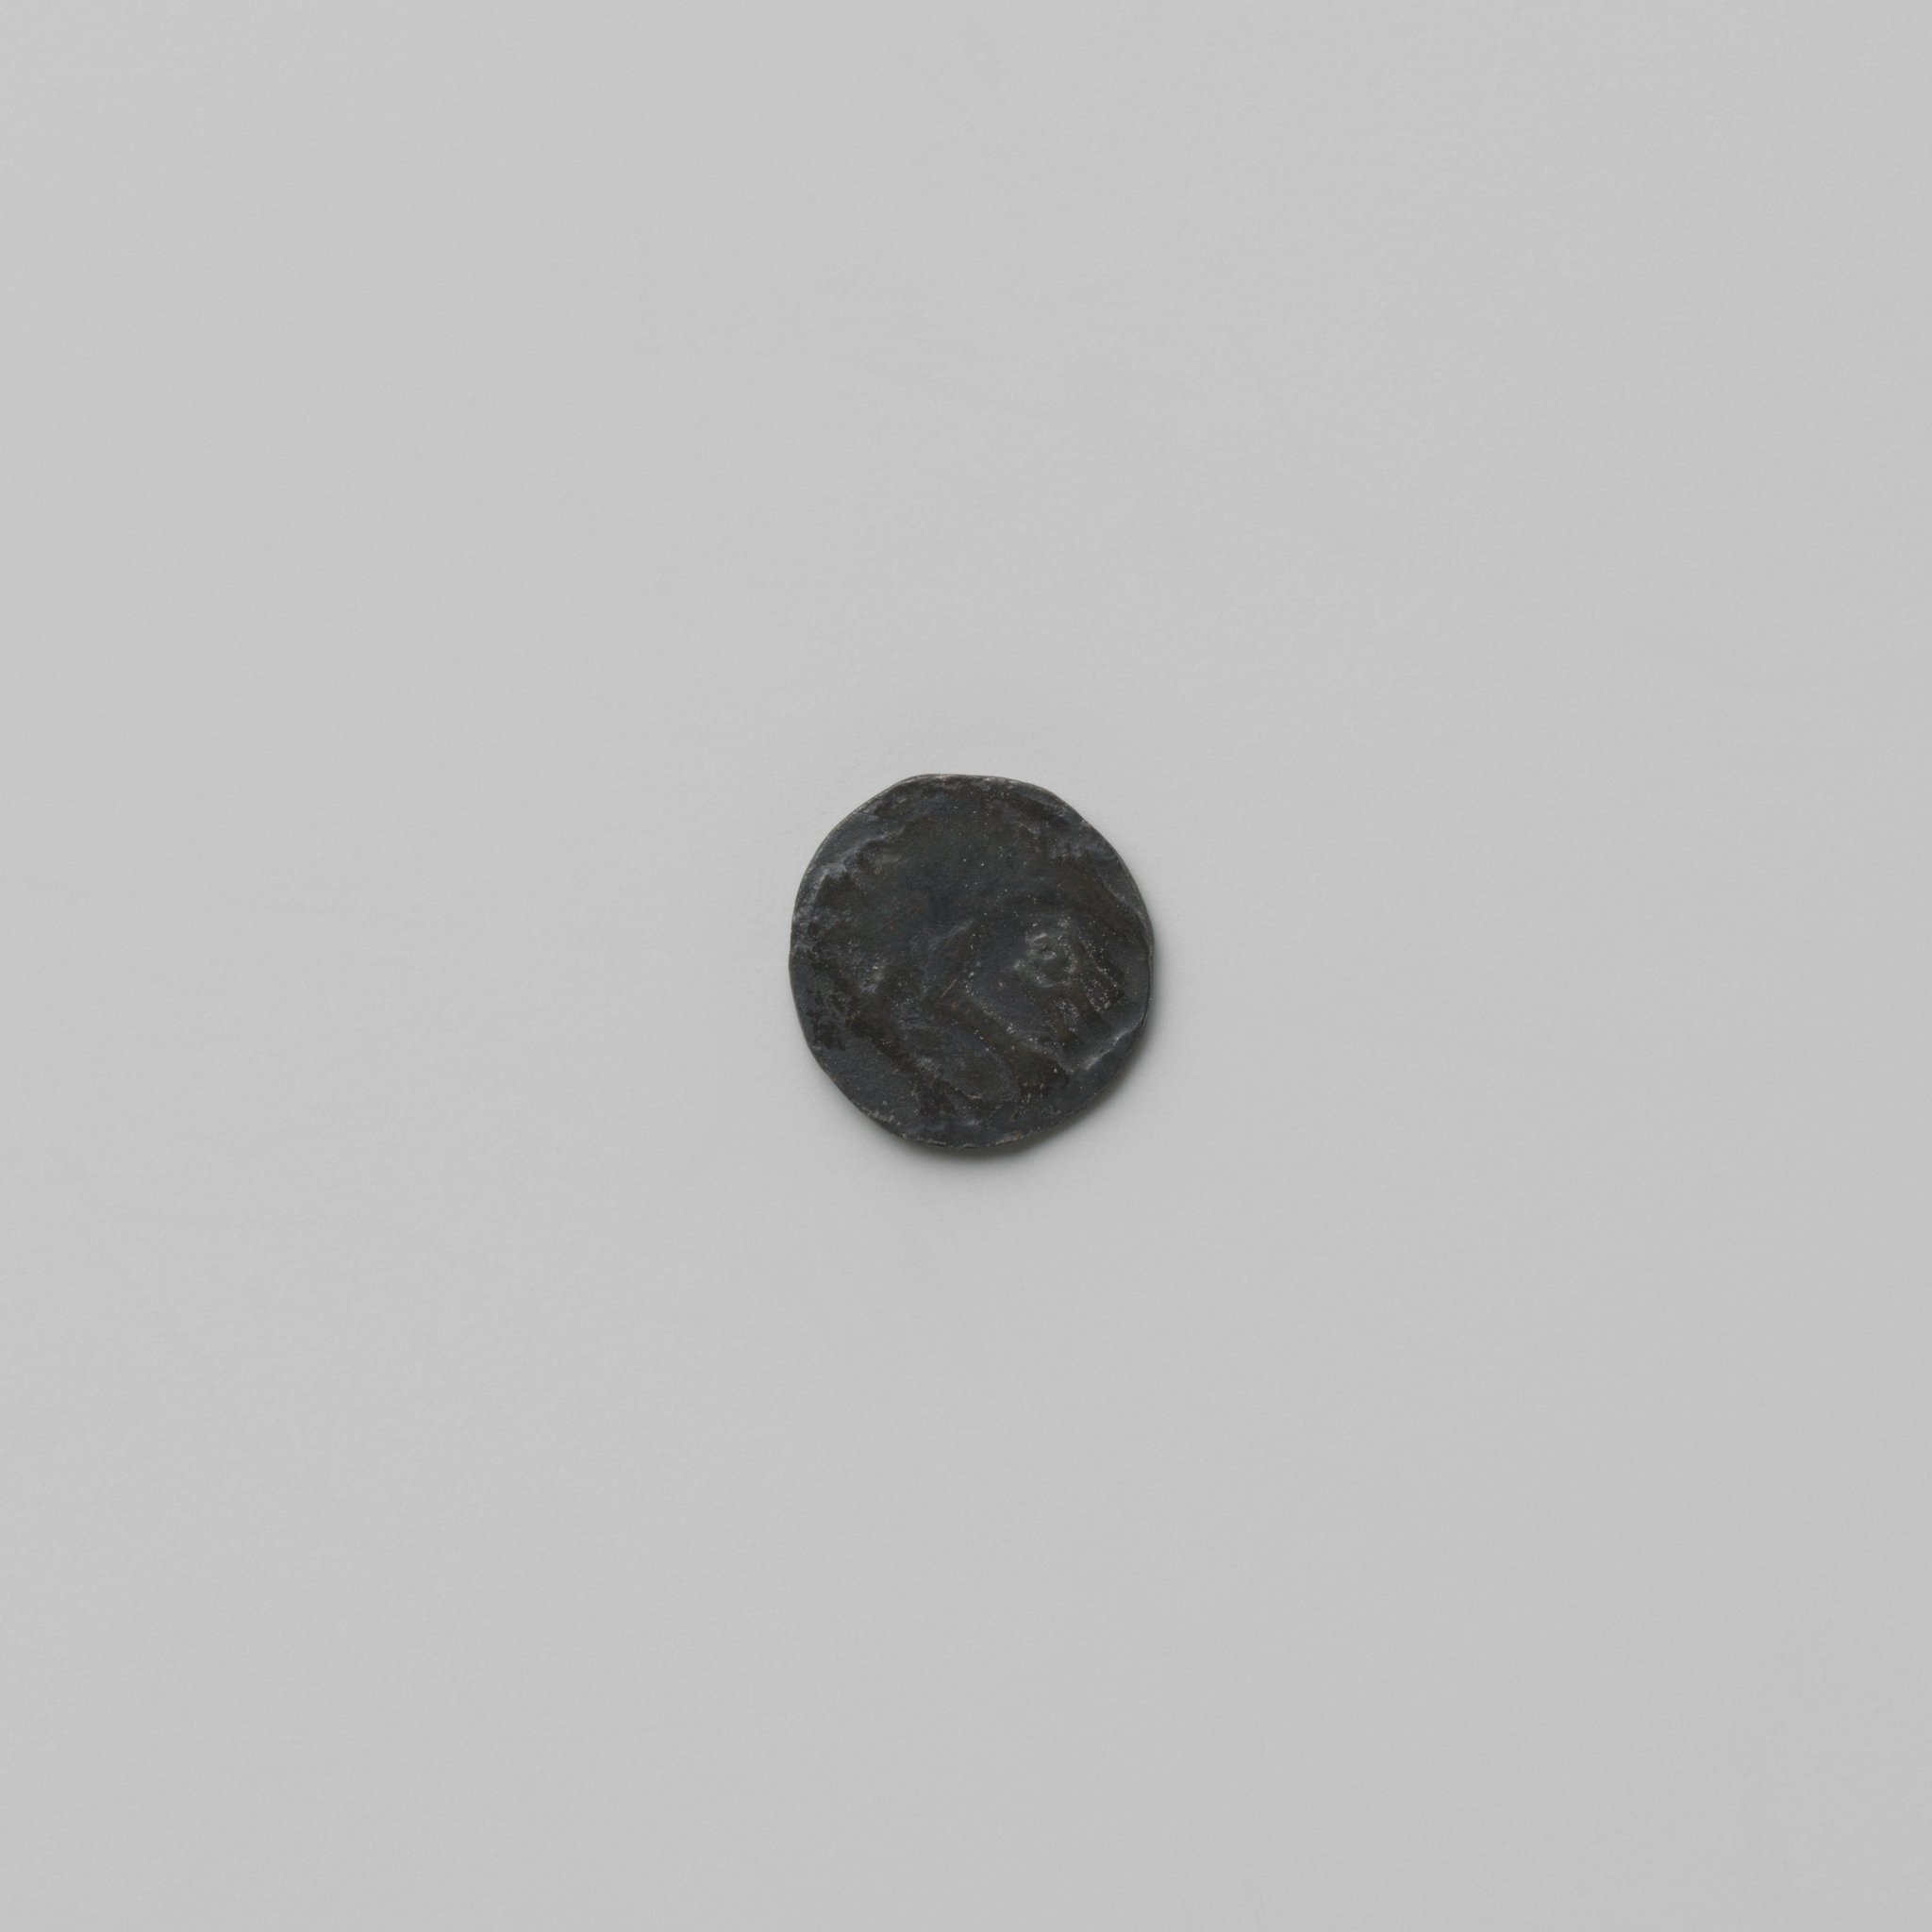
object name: miniature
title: Russische kopek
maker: Anonymous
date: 1650-1710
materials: silver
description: Zilveren muntje; Russisch kopek met ronde vorm, van Alexis Michaelowitz, czaar van Rusland (1645 - 1676).